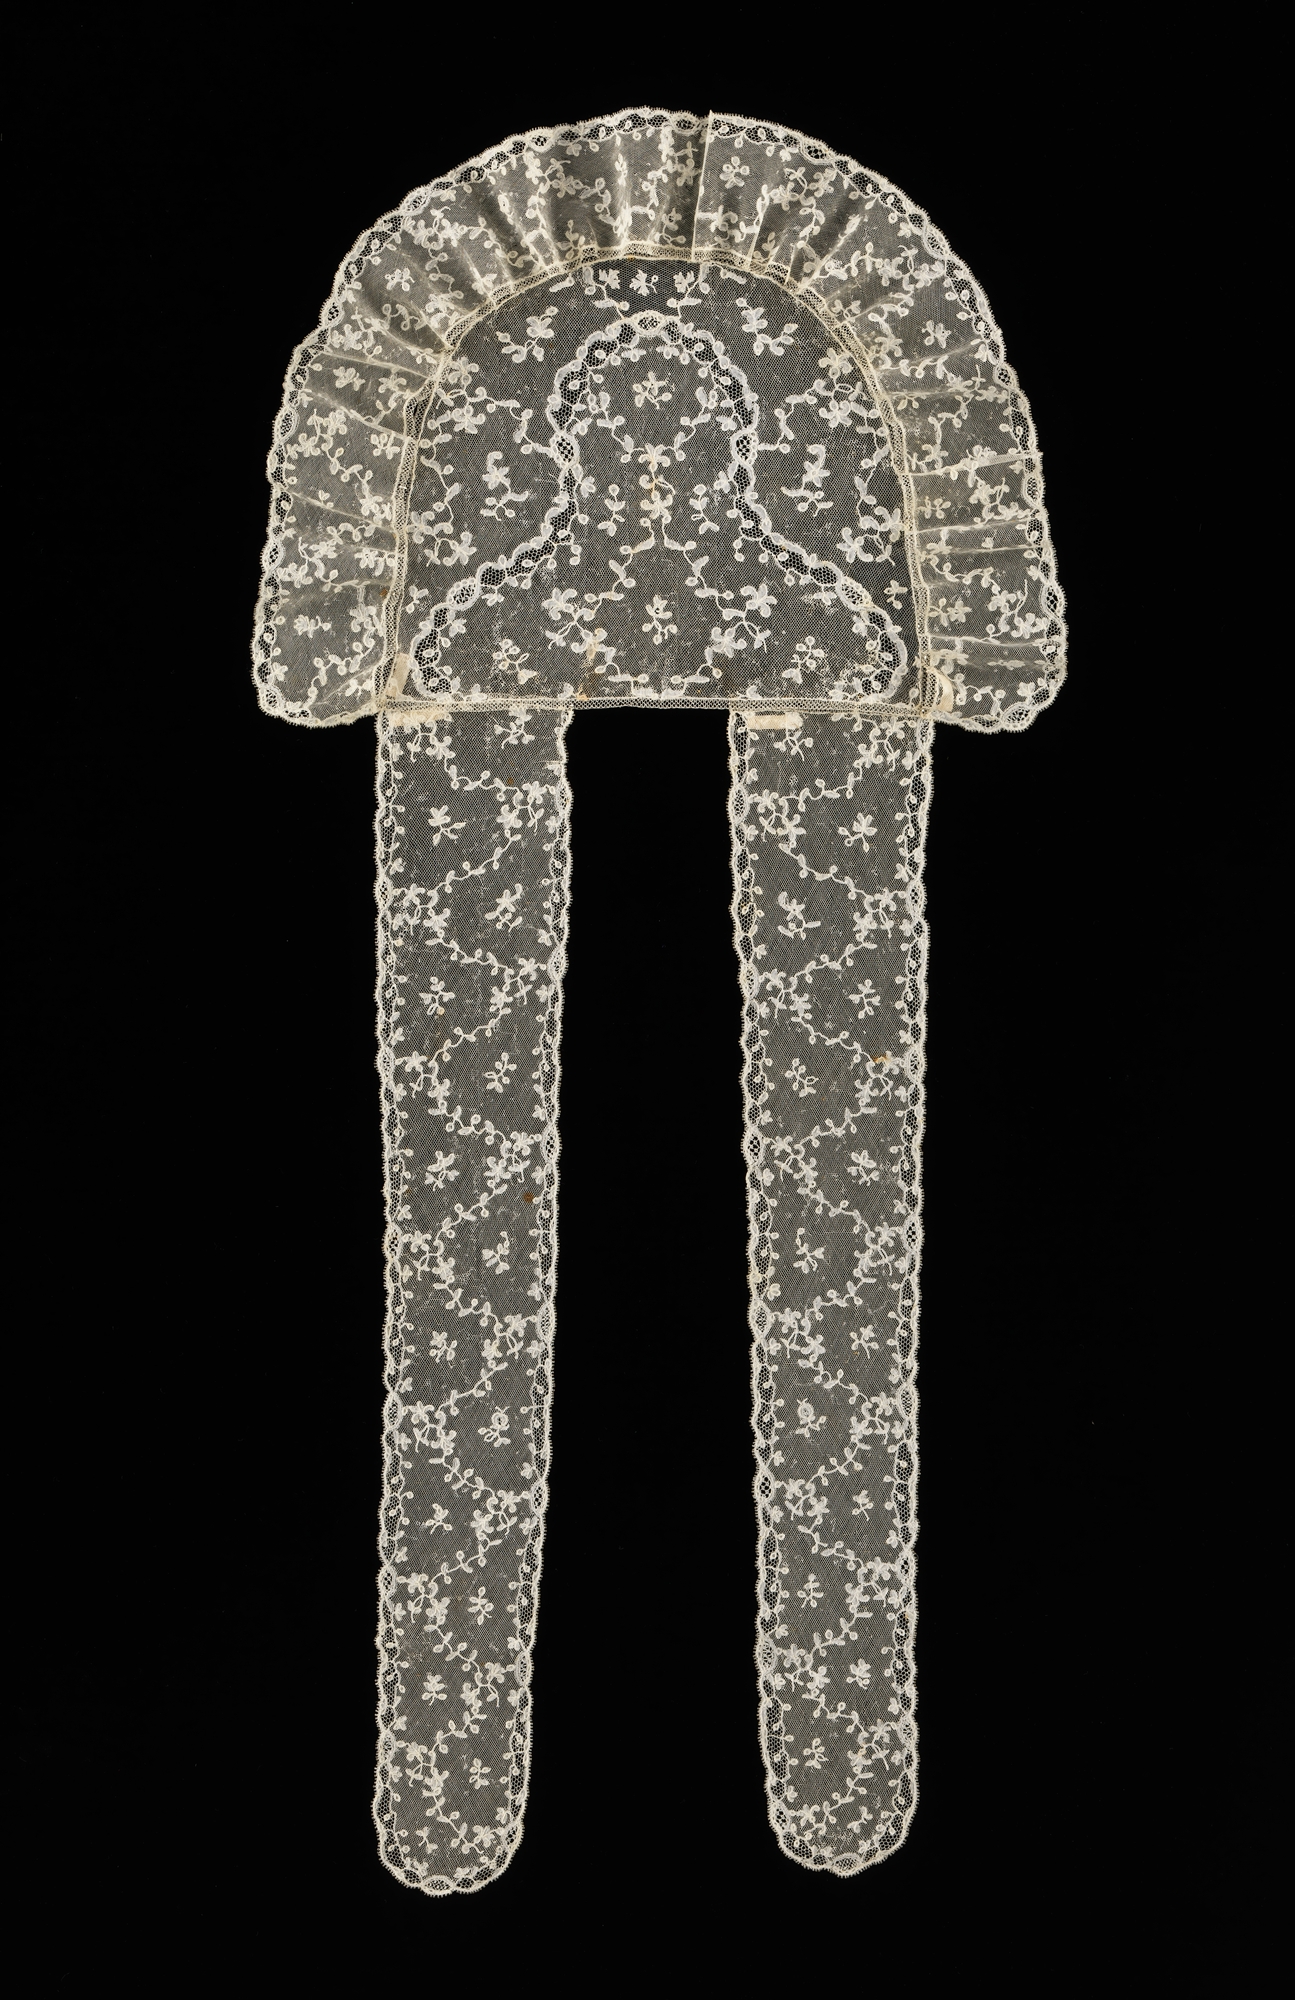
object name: accessory set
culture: french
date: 1750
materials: linen